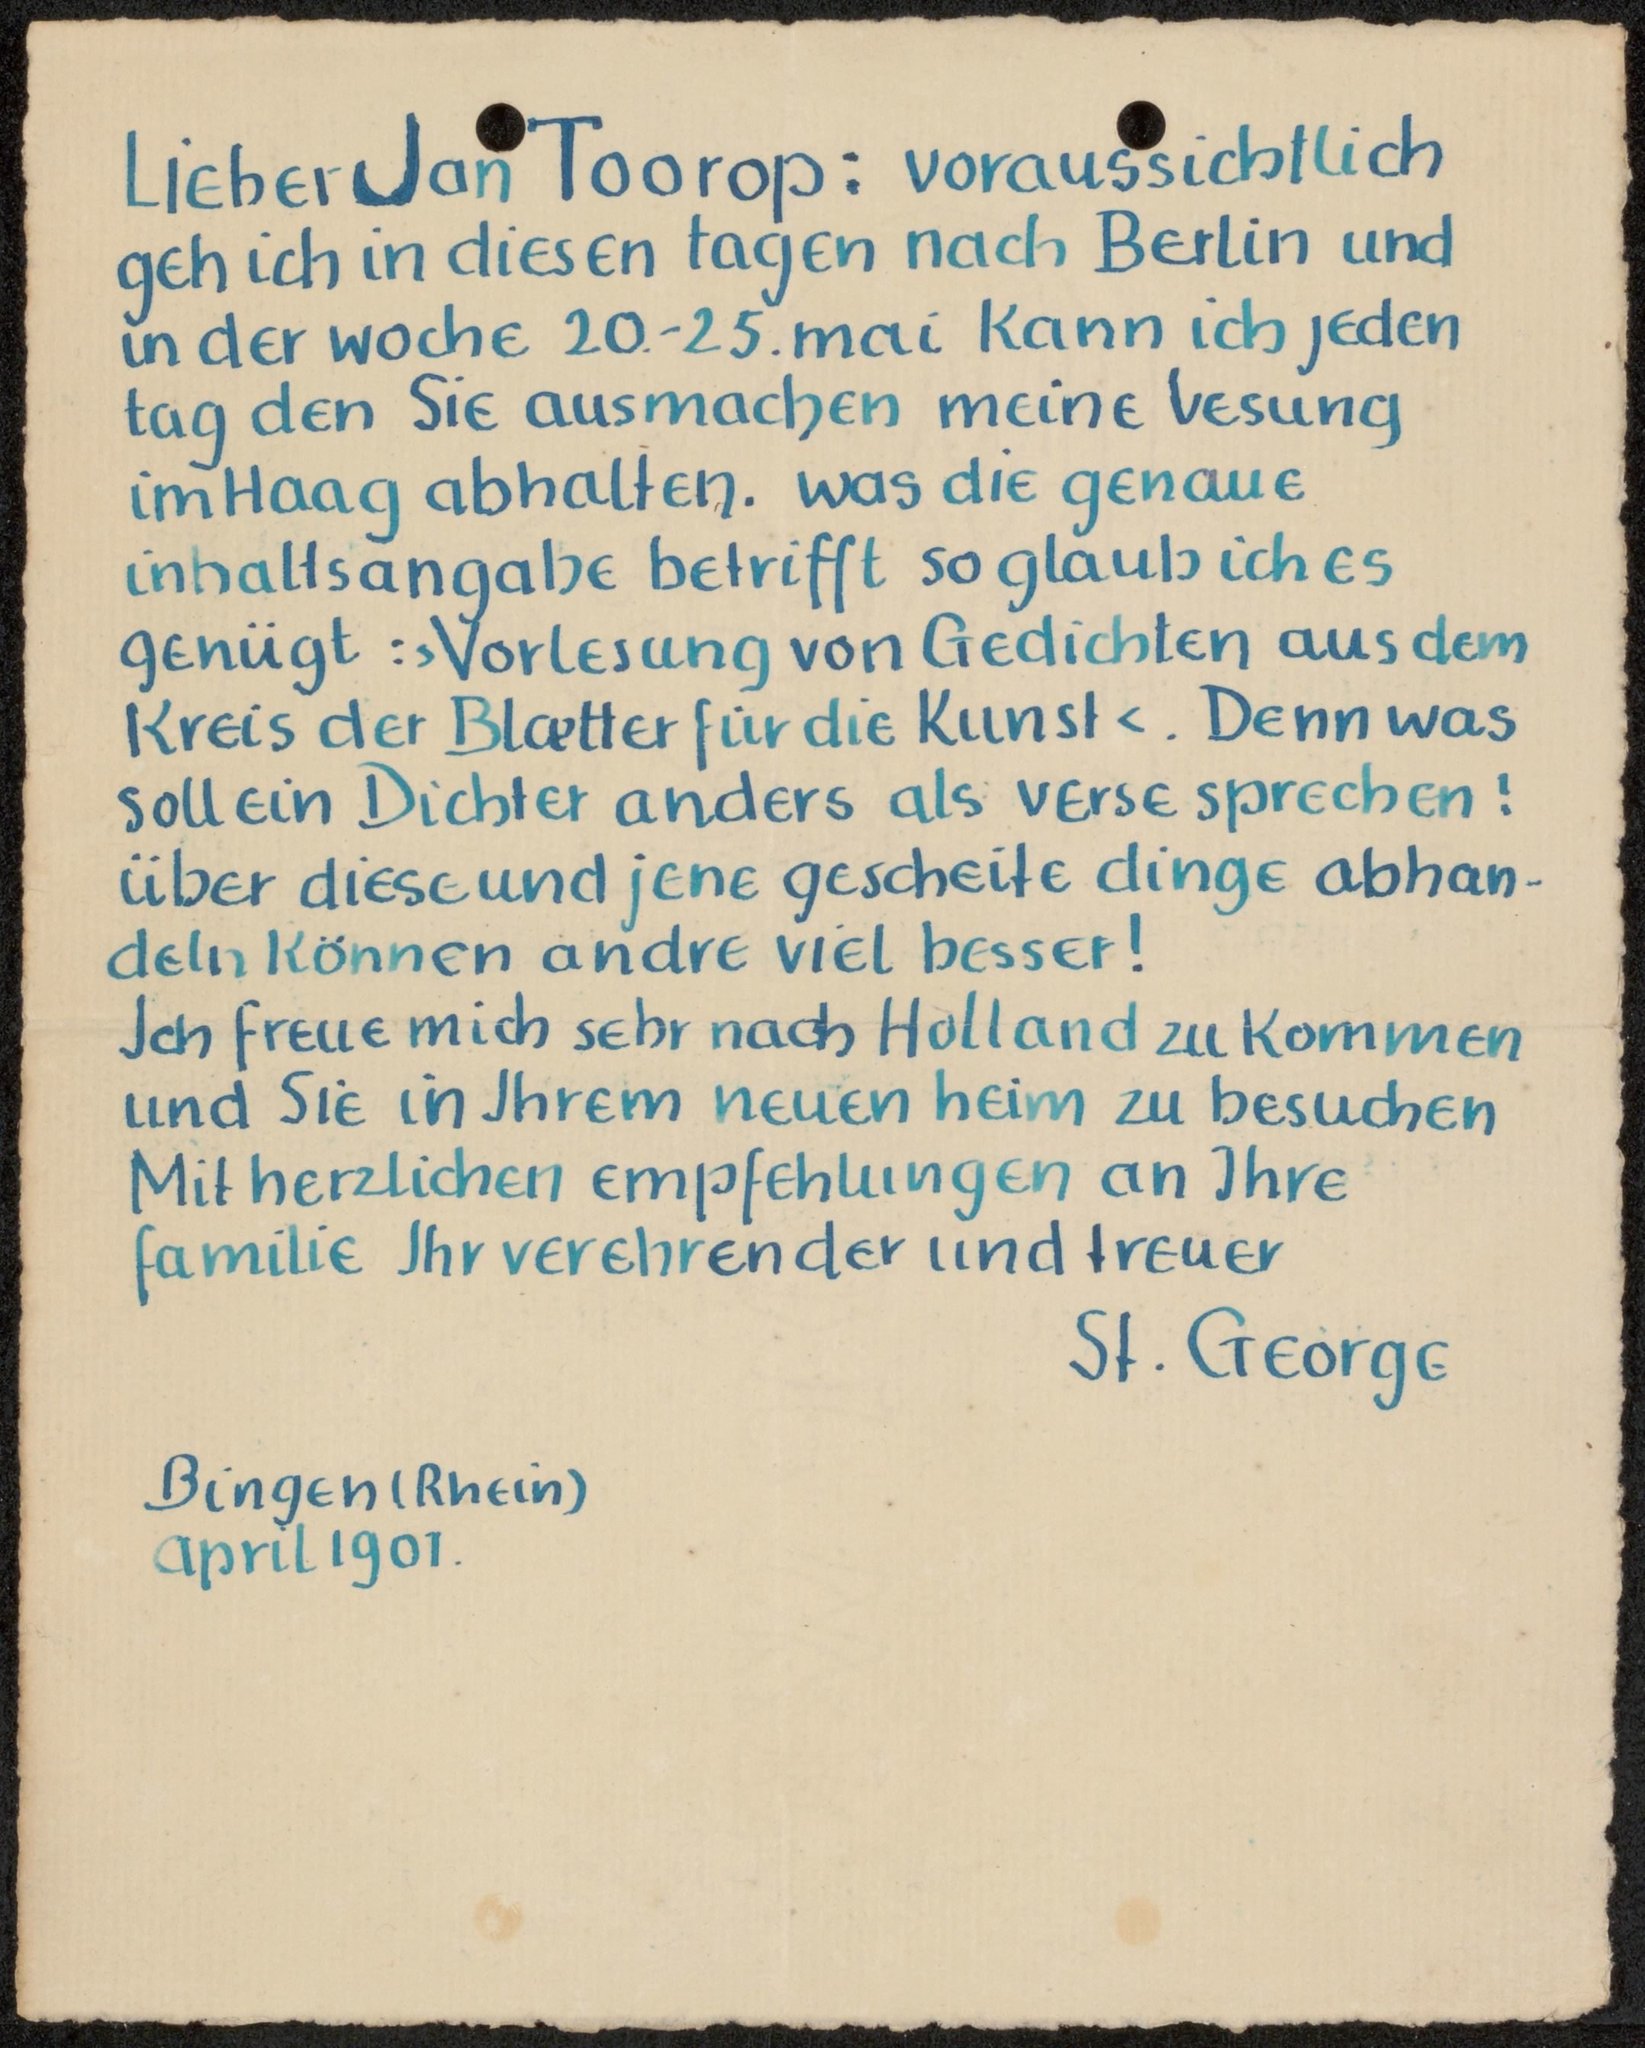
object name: letter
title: Brief aan Jan Toorop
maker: stefan george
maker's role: dichter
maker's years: 1868-1933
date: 1901-1904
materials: ink, paper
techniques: pen, writing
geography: bingen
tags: print maker, jan toorop, draughtsman, philip zilcken, literature ~ arts, the hague, berlin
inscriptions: collector's mark: ‘RPK’, watermark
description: Brief is bewaard bij correspondentie aan Philip Zilcken.